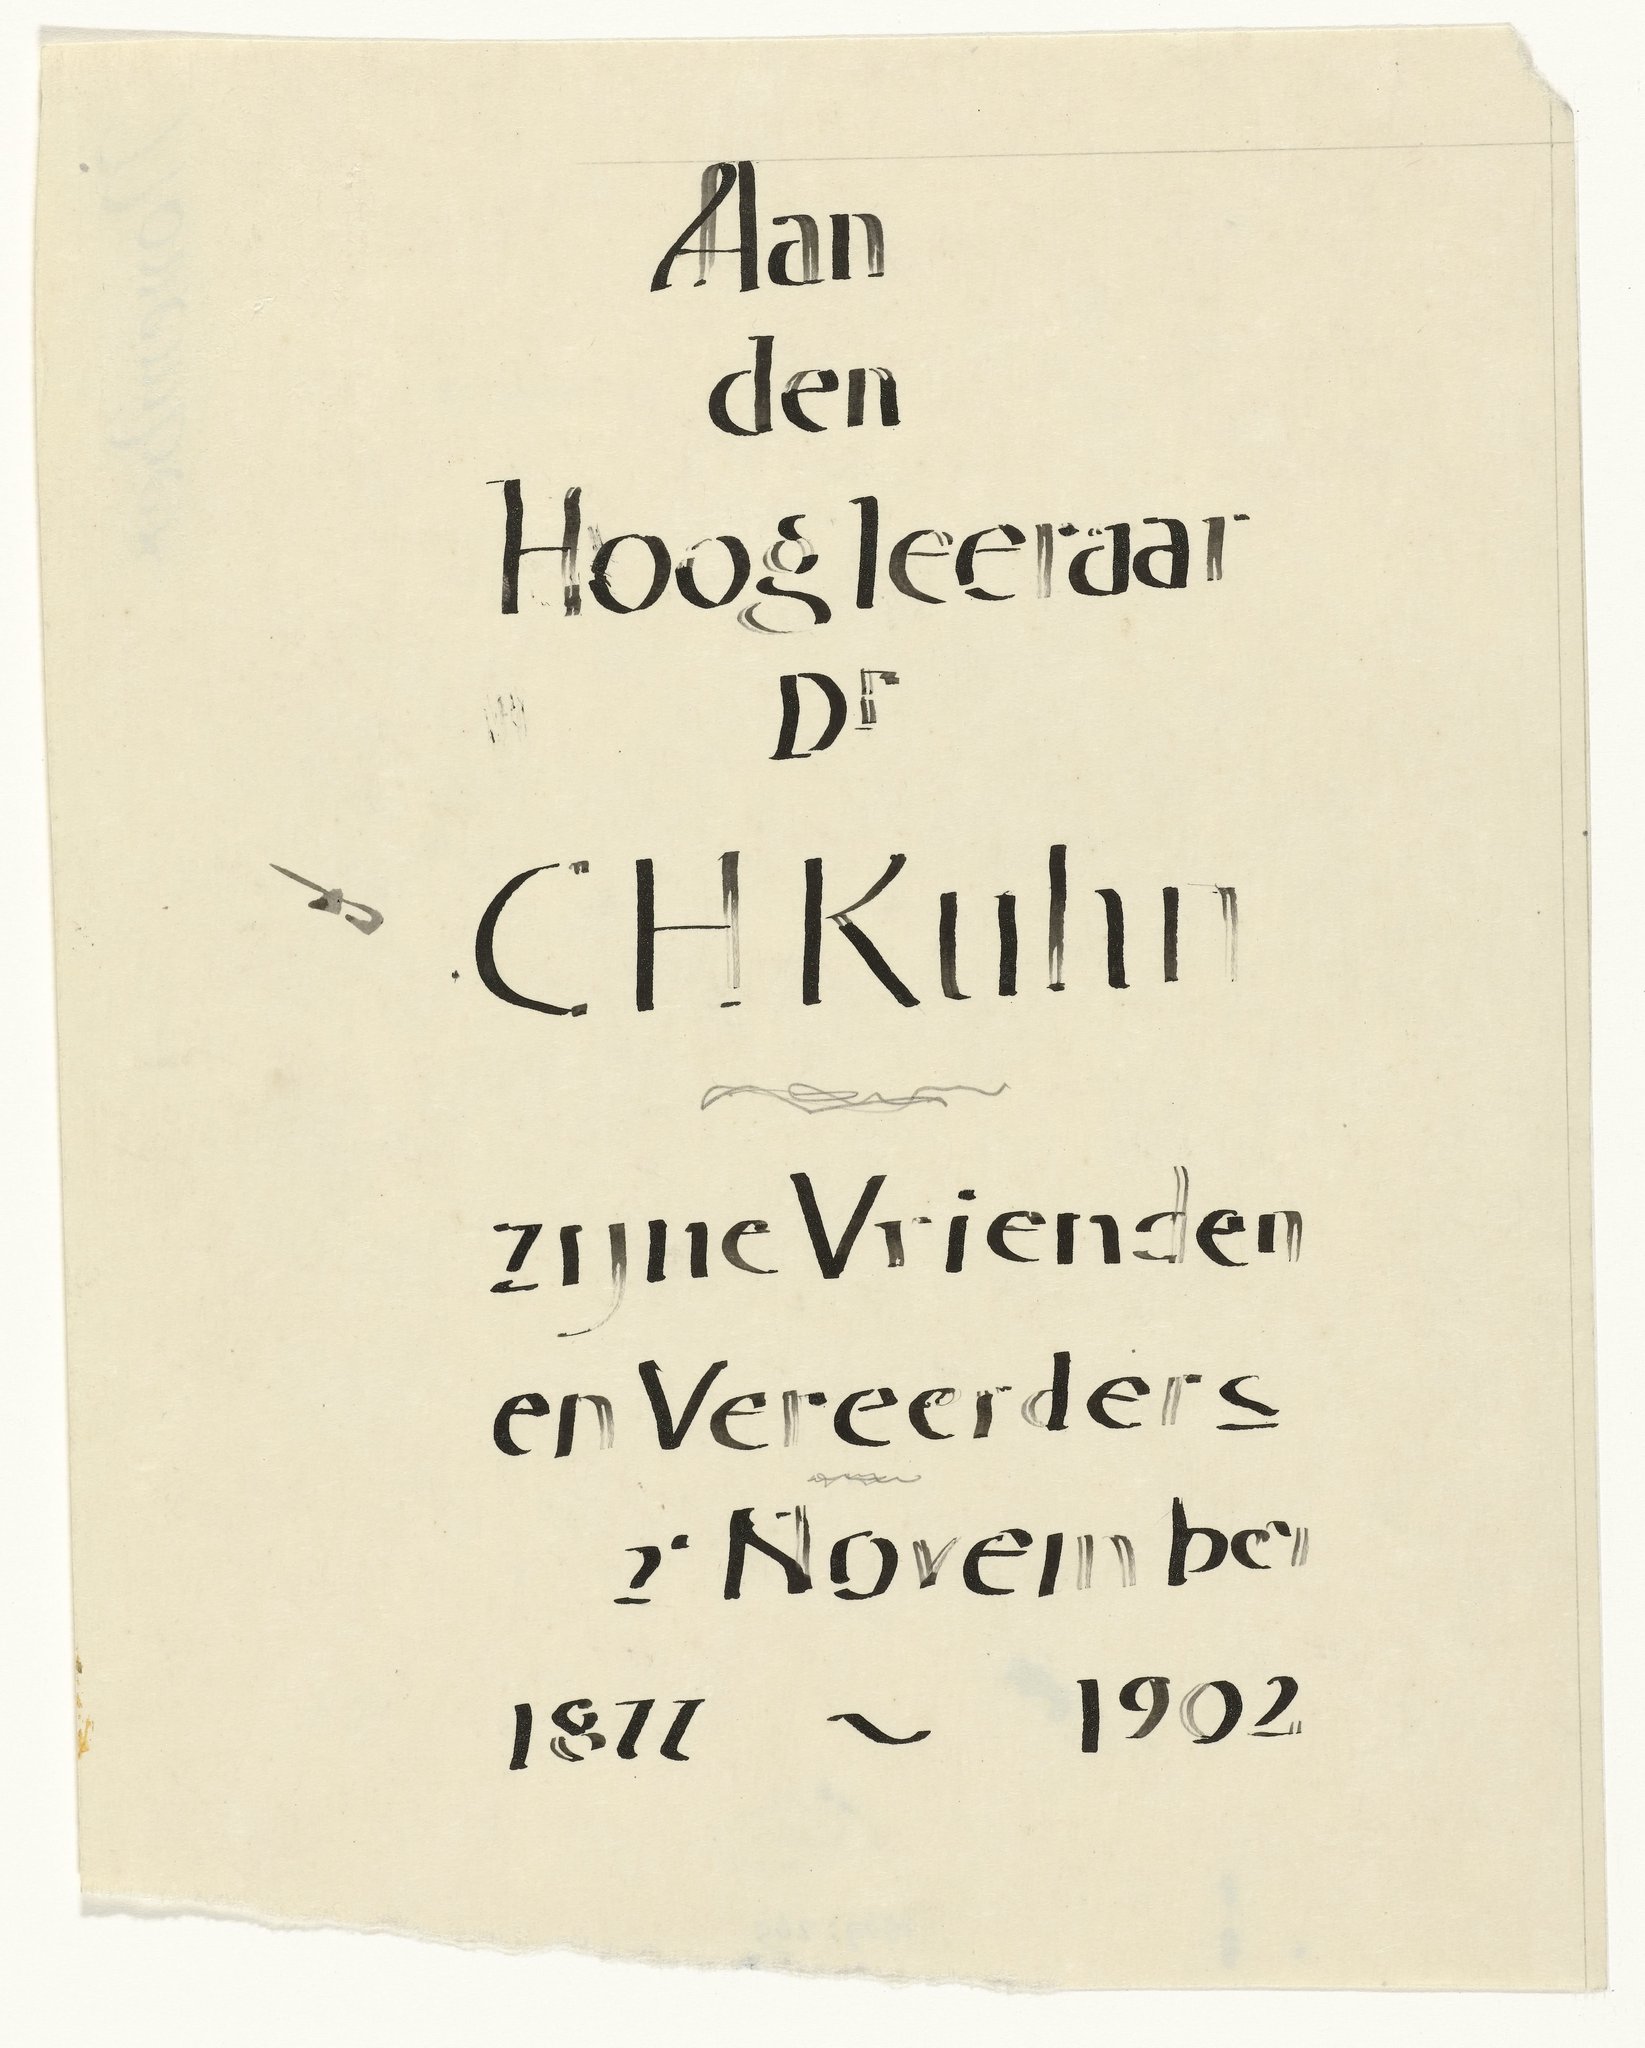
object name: drawing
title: Tekst ter gelegenheid van het 25-jarig jubileum van prof. dr. C.H. Kuhn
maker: gerrit willem dijsselhof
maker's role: designer, draughtsman, print maker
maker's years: 1866-1924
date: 1876-1924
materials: paper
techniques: brush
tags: historical persons, handwriting, written text